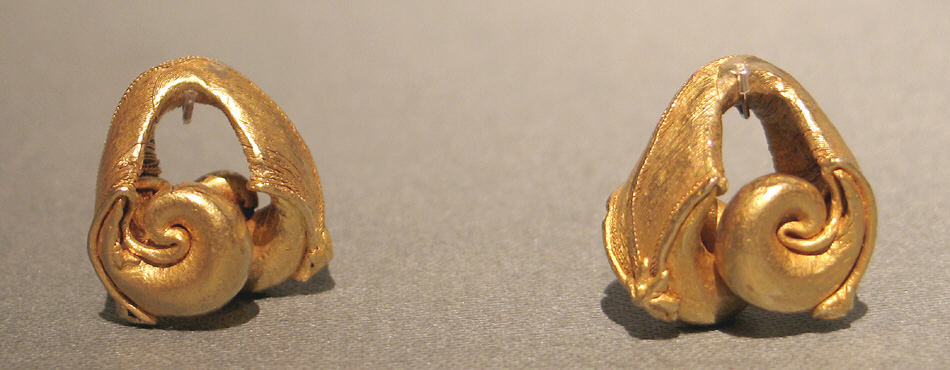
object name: earring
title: Pair of Earrings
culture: indonesian, javanese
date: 701-833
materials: gold